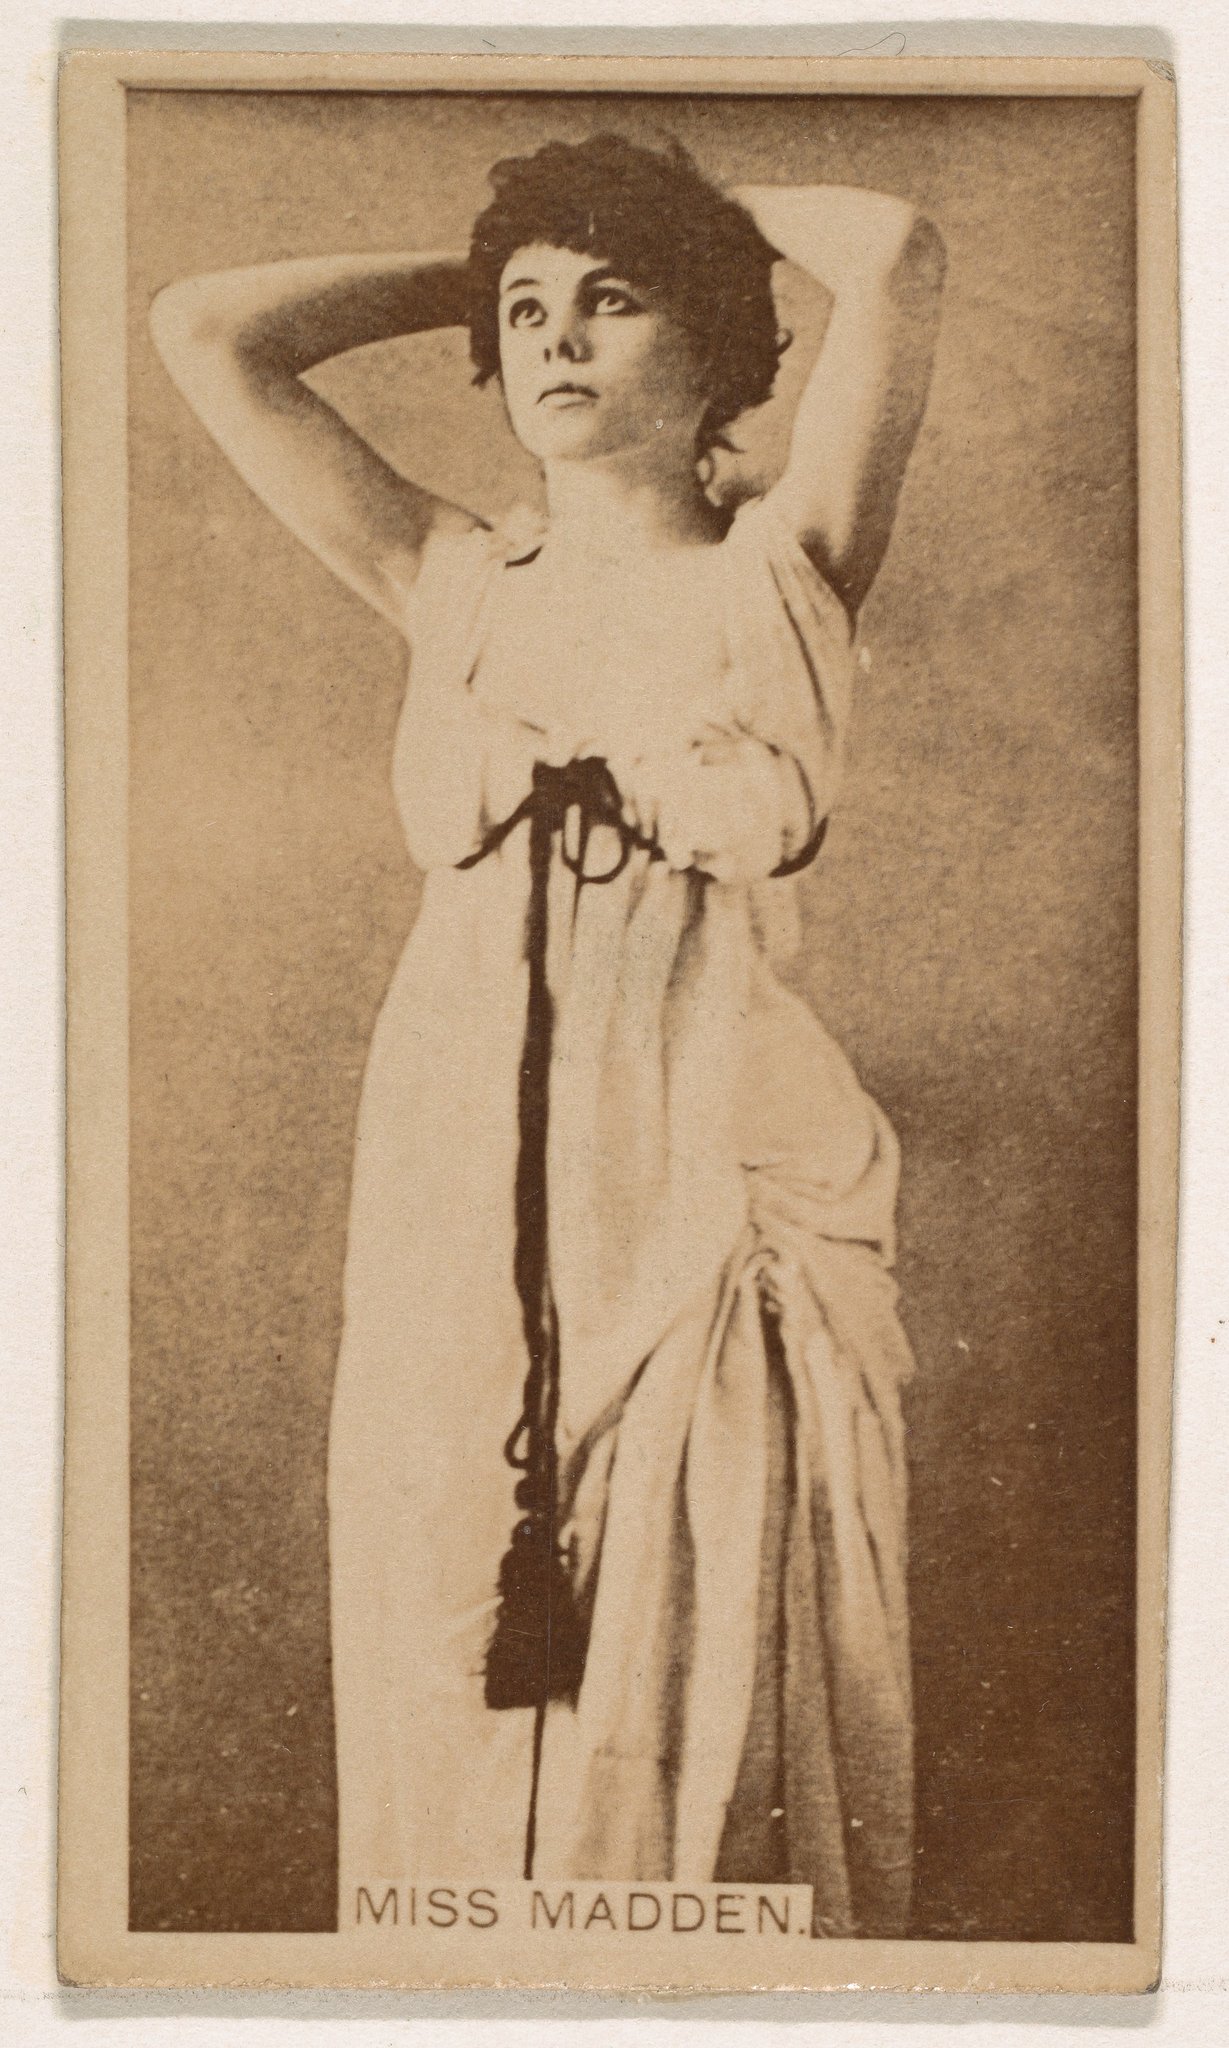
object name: photograph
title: Miss Madden, from the Actresses series (N245) issued by Kinney Brothers to promote Sweet Caporal Cigarettes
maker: kinney brothers tobacco company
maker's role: publisher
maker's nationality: american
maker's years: 1869-2011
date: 1890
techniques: albumen silver print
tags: portraits,women,actresses